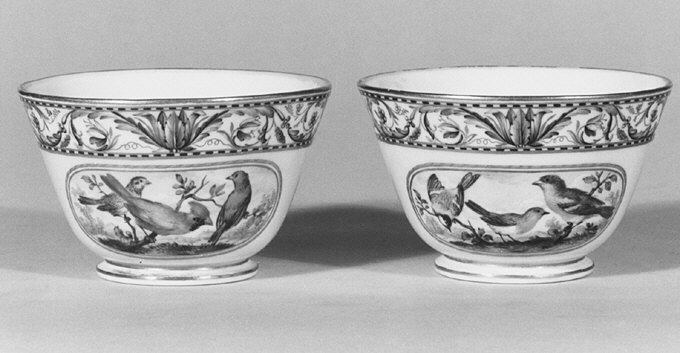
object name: saucer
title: Saucer (part of a service)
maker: meissen manufactory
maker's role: manufactory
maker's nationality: german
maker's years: 1710-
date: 1780-1785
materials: hard paste porcelain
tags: birds